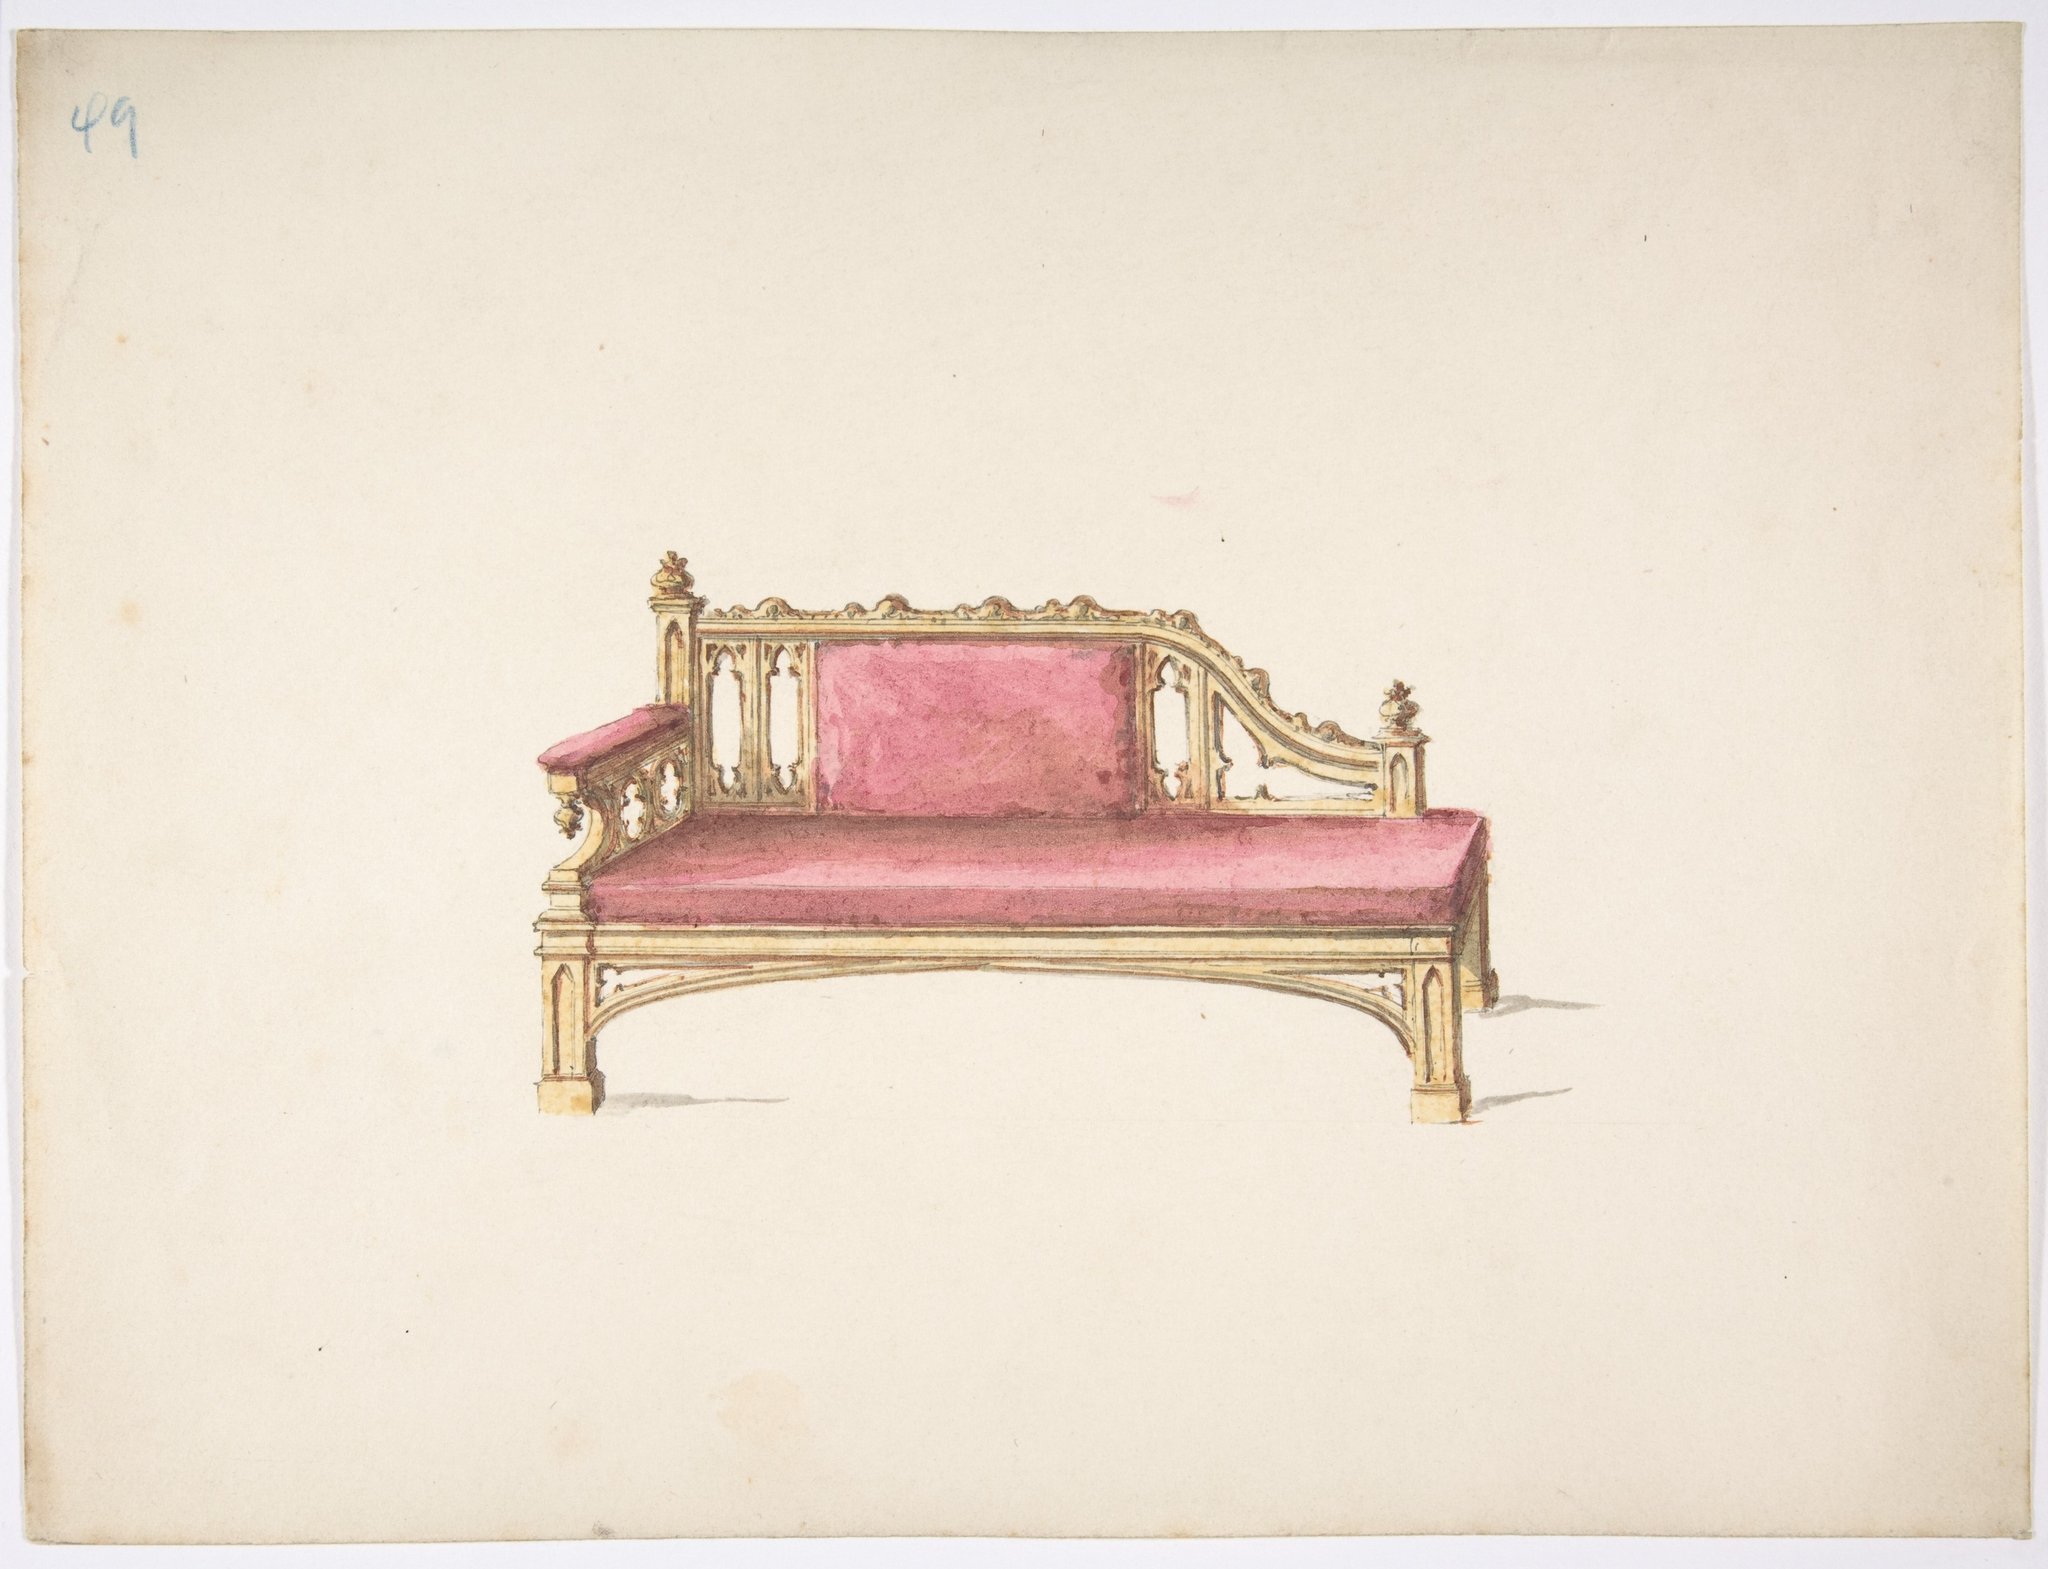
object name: drawing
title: Design for a Gothic Style Sofa Upholstered in Red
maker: anonymous, british, 19th century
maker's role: artist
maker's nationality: british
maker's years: 1800-1900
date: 1801-1833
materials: ink, watercolor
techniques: brush, pen, wash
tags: couches